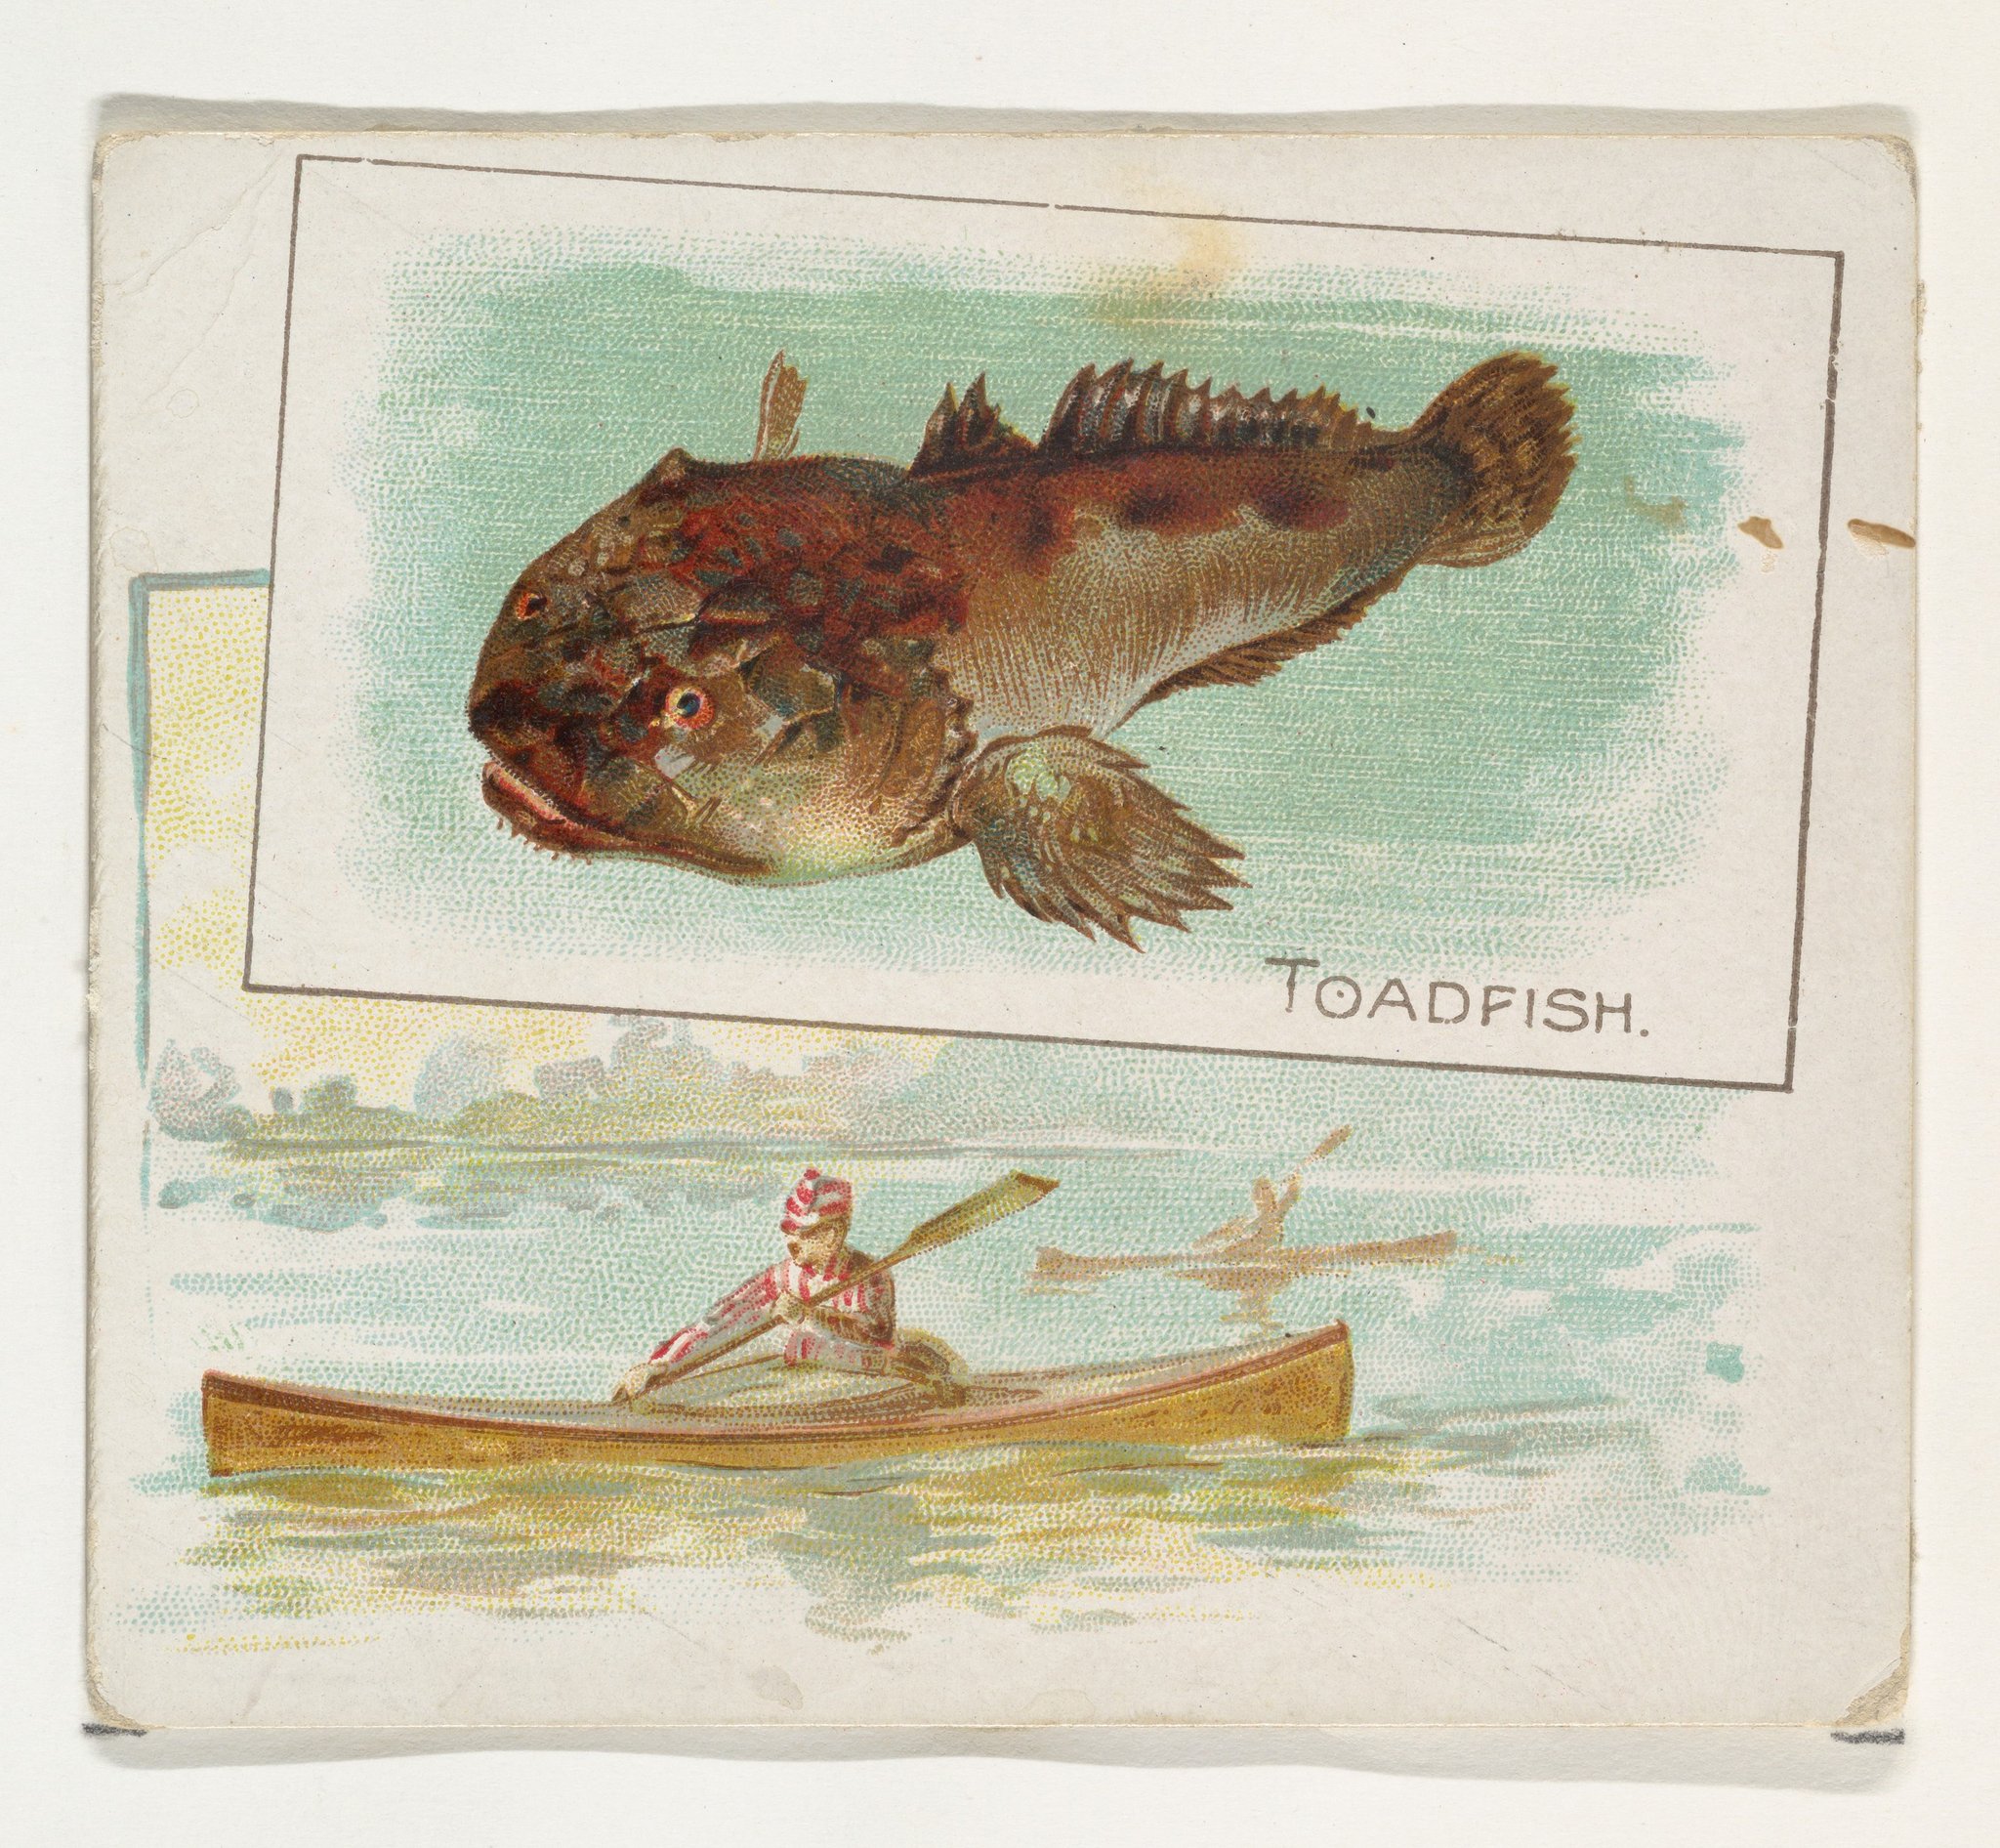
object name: print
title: Toadfish, from Fish from American Waters series (N39) for Allen & Ginter Cigarettes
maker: allen & ginter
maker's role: publisher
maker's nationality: american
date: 1889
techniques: color lithograph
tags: men,fish,boats